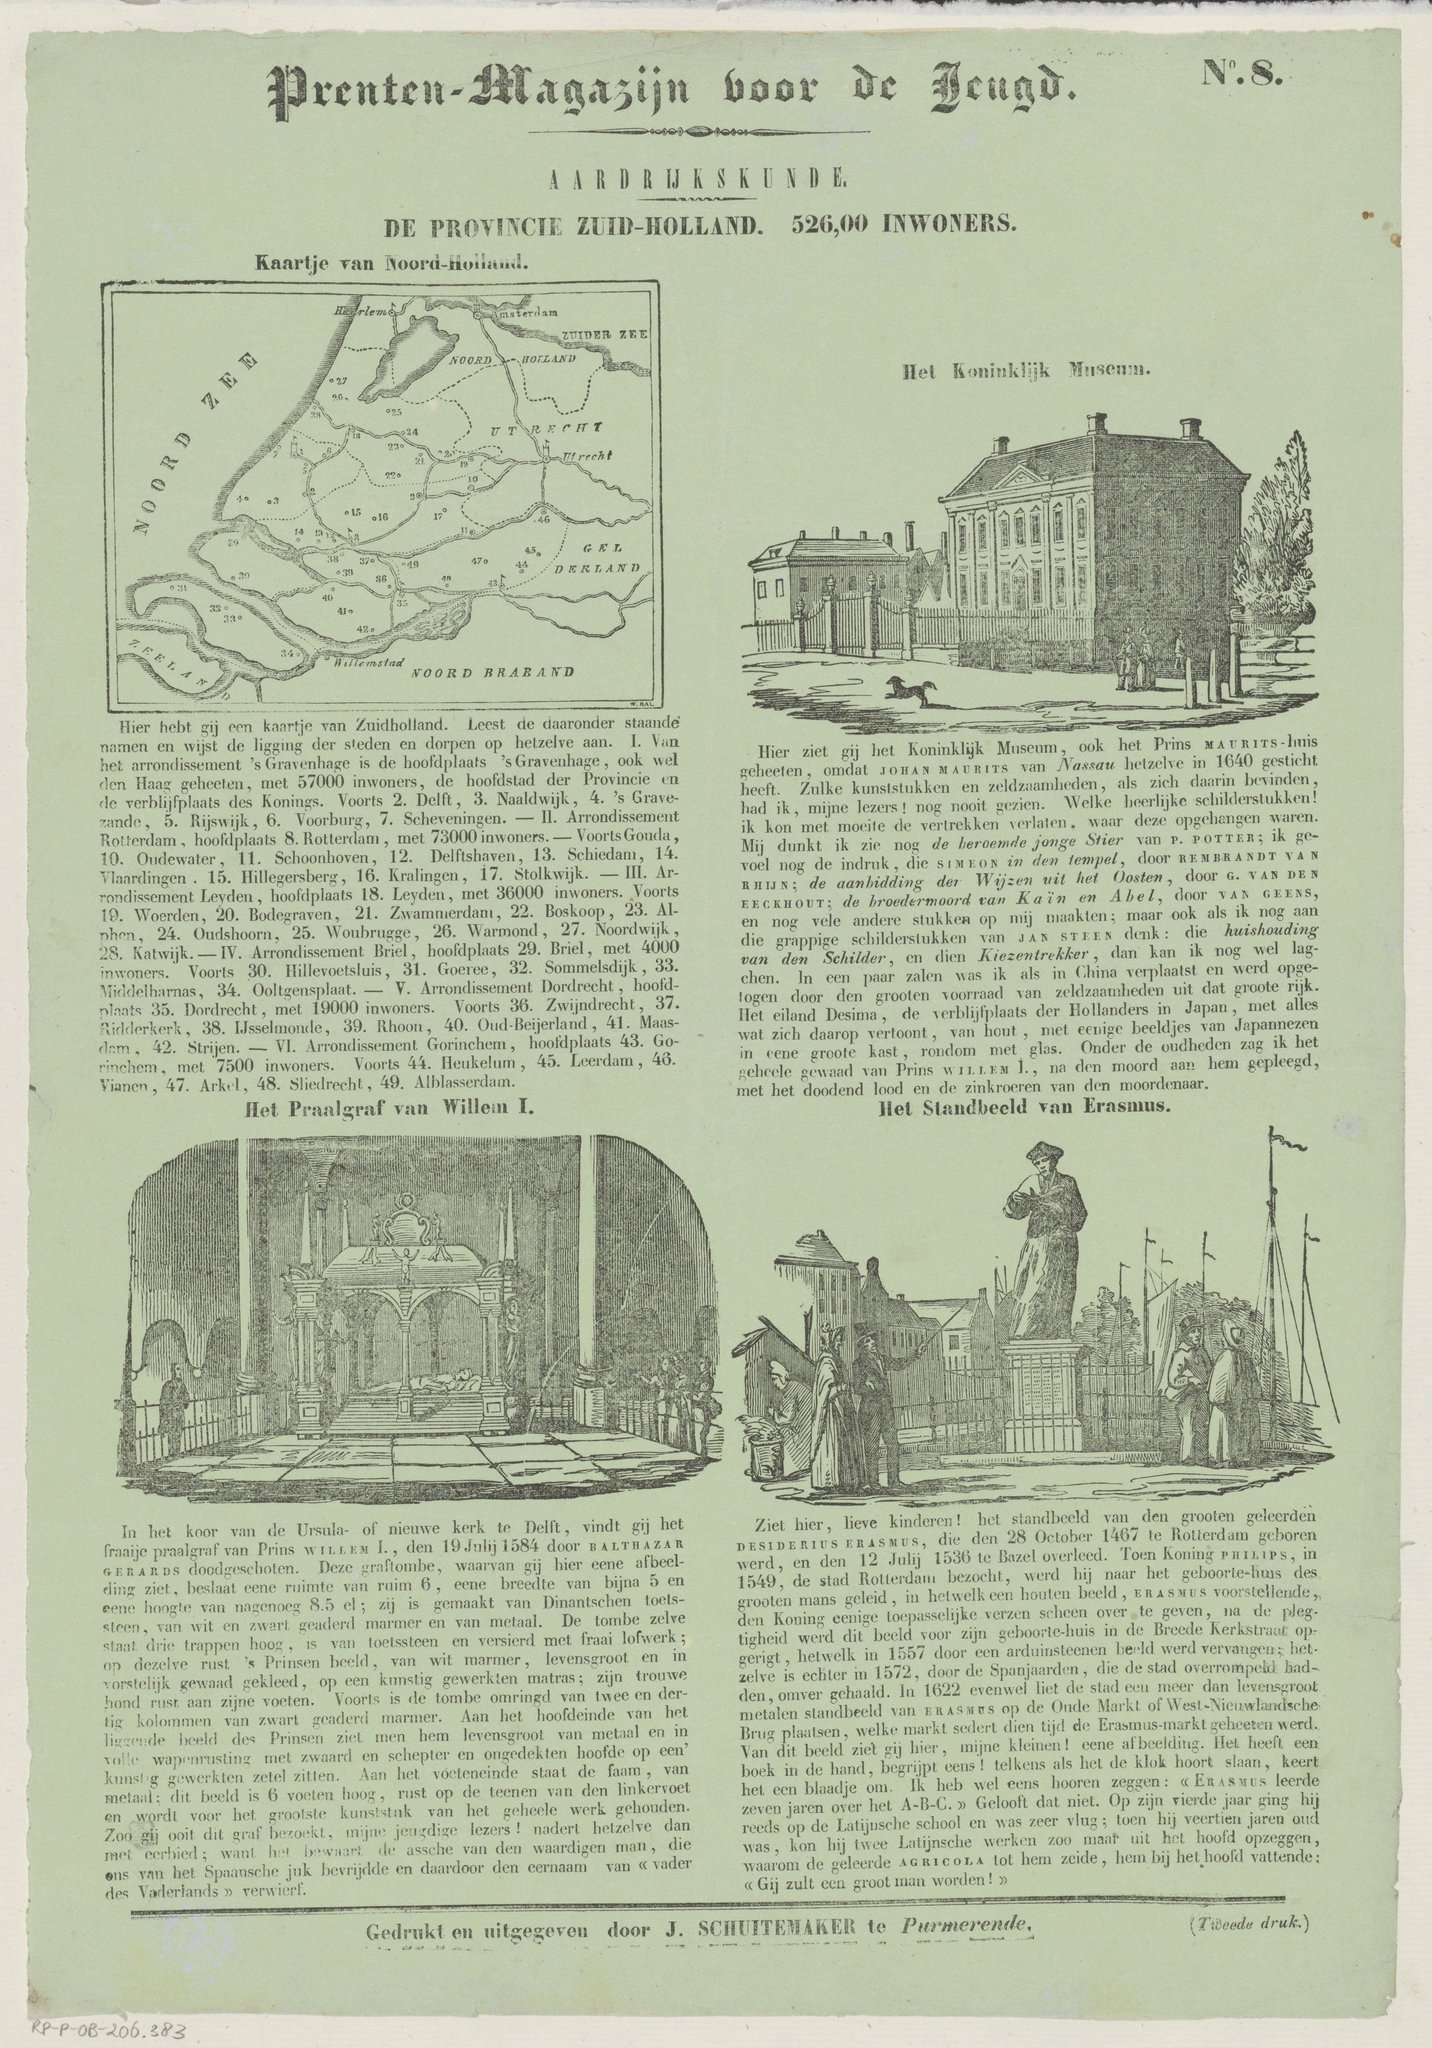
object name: popular print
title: De provincie Zuid-Holland. 526,000 inwoners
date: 1842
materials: paper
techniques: letterpress printing, engraving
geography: purmerend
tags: desiderius erasmus, the hague, berlin, william i of the netherlands, maps, atlases, grave, tomb, monument, statue, permanent exhibition, museum, delft, rotterdam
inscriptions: collector's mark: Lugt 2760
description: Blad met 4 voorstellingen over de provincie Zuid-Holland met een kaart en belangrijke gebouwen en monumenten: het Mauritshuis in Den haag, het Praalgraf van Willem I in Delft en het standbeeld van Erasmus in Rotterdam. Boven elke voorstelling een titel en onder elke voorstelling een onderschrift. Genummerd rechtsboven: No. 8.